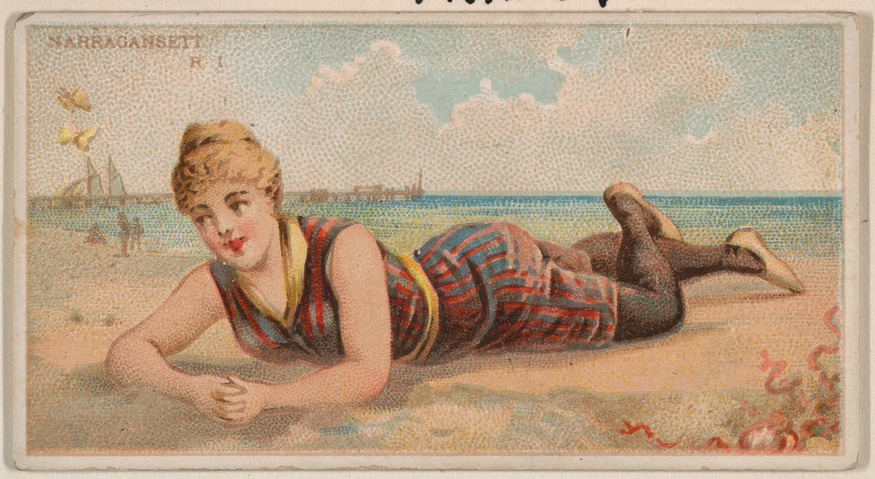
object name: print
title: Narragansett, Rhode Island, from the Surf Beauties series (N232), issued by Kinney Bros.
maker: kinney brothers tobacco company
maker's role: publisher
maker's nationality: american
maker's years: 1869-2011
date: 1889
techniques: color lithograph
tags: women